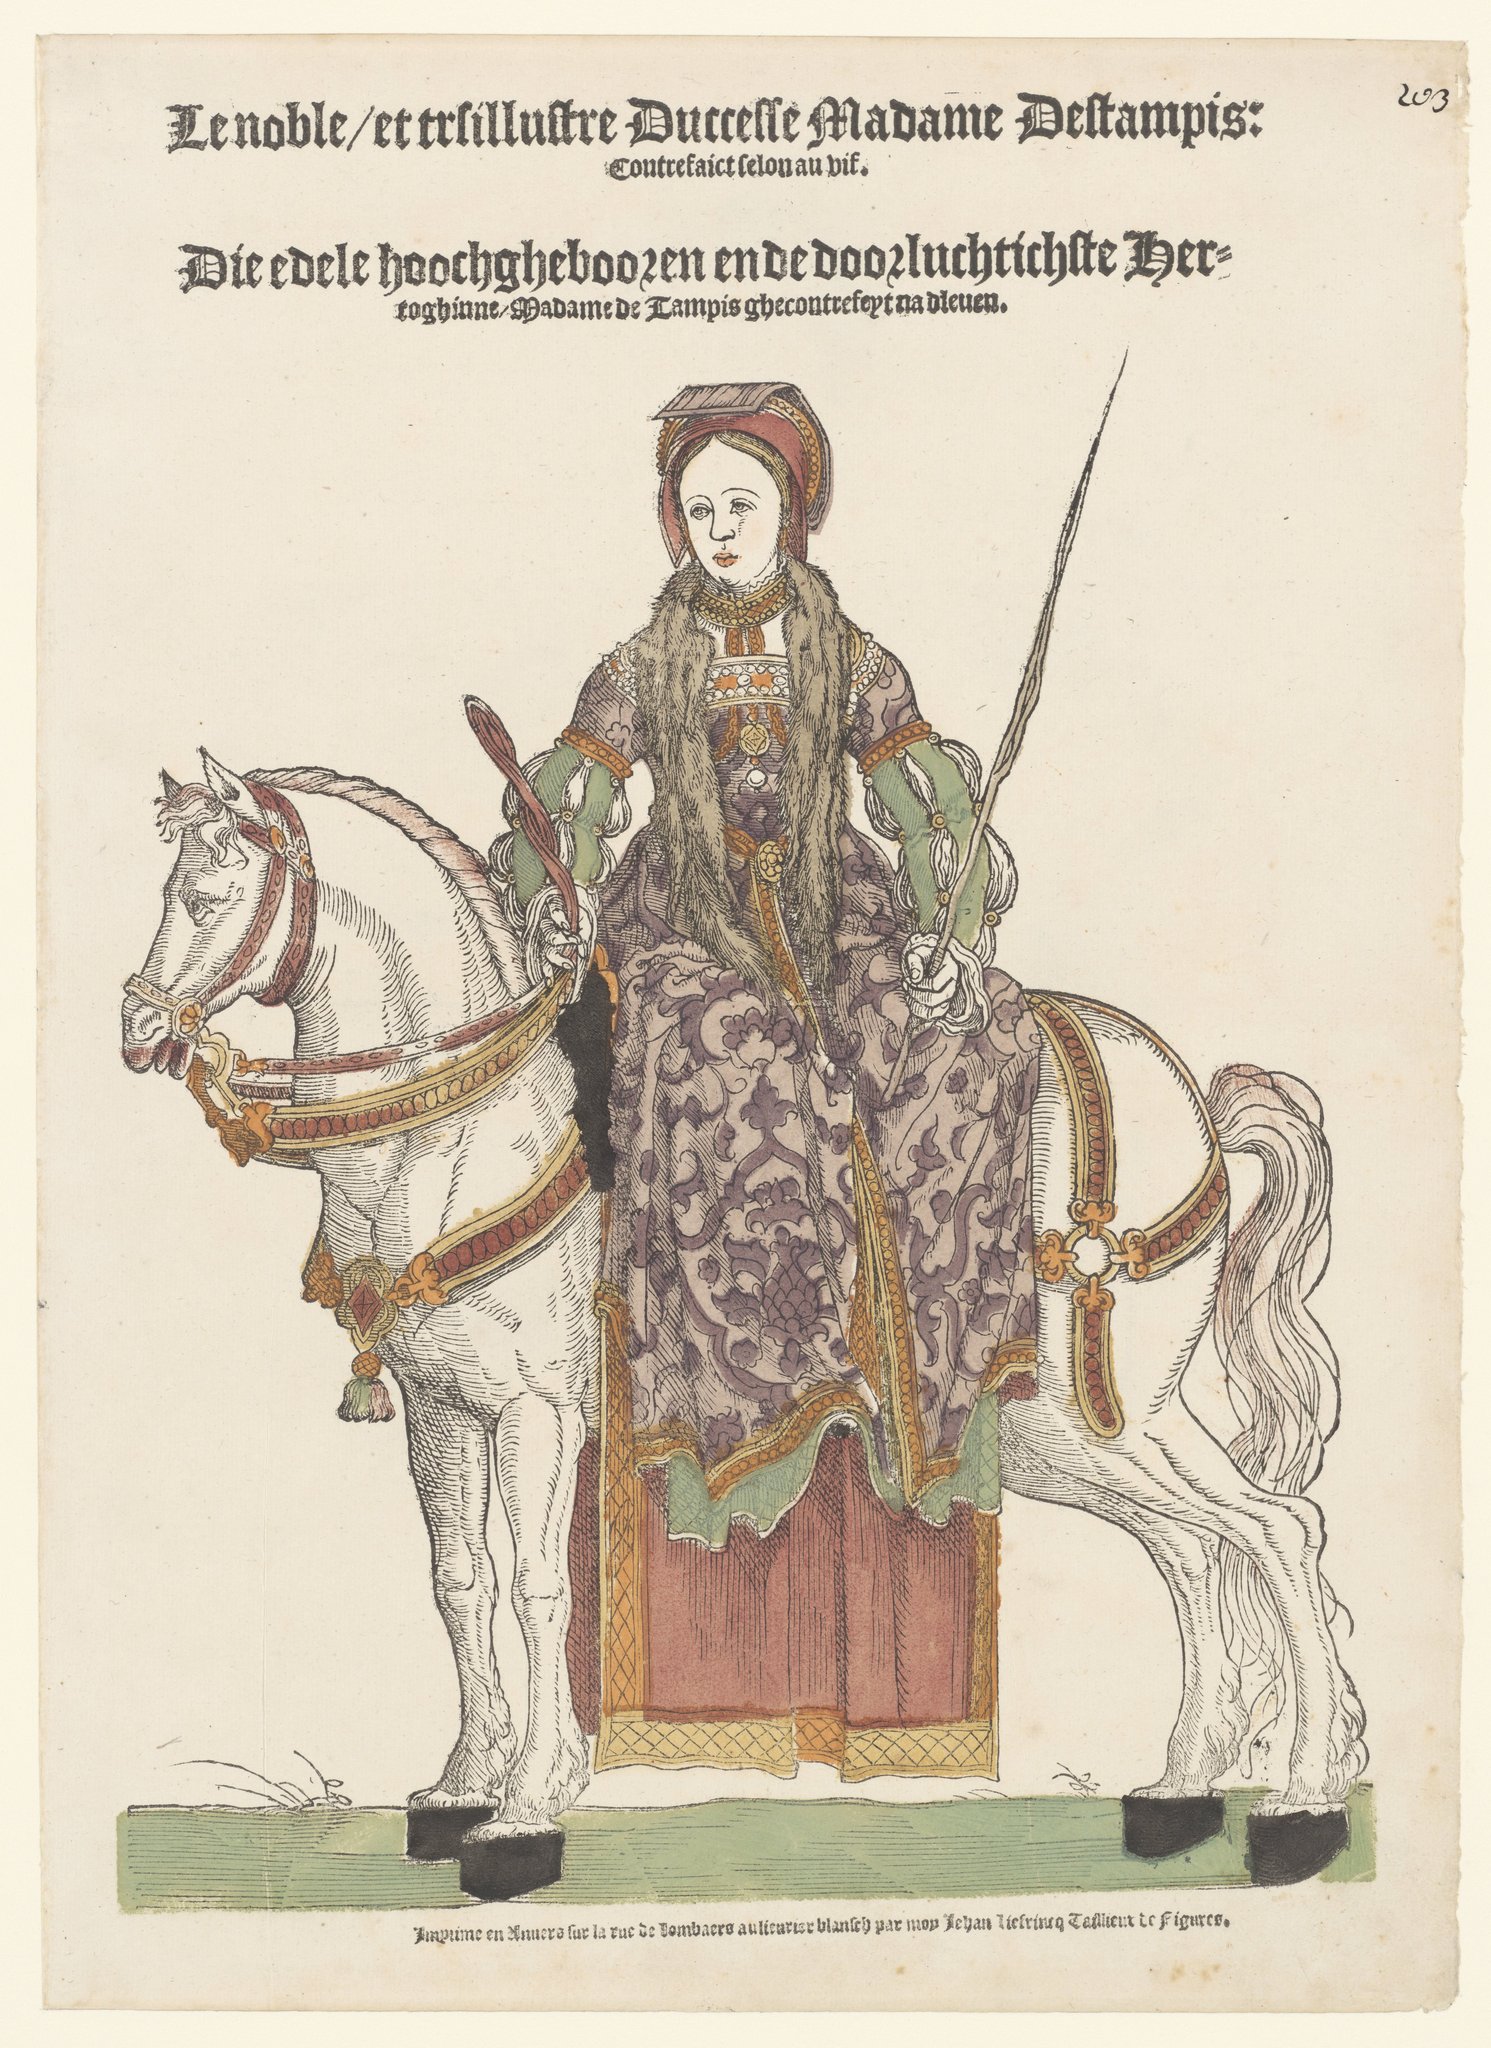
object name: print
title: Portret van Anne de Pisseleu te paard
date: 1539-1553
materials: paper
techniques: hand coloring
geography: antwerp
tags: equestrian state-portrait, historical persons - bb - woman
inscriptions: number: ‘203’, inscription: ‘Le noble/ et tel illustre Duchesse Madame Destampis: Contrefaict selon au vif. Die edele hoochghebooren ende doorluchtichste Her-toghinne/ Madame de Tampis ghecontrefeyr na dleven’, address: ‘Imprime en Anvers sur la rue de Lombaers....Jehan Liefrincq Tailleur de Figueres’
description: Anne de Pisseleu, hofdame van koningin-moeder Louise van Savoye en sinds 1530 maîtresse van Frans I(1494-1547) die haar in 1533 uithuwelijkte aan Jean de Brosses aan wie hij, bij die gelegenheid, de titel Comte d'Etampes toekende. Anne d'Etampes behield haar invloed aan het hof tot aan de dood van Frans I. Zij is afgebeeld als amazone op een stilstaand paard. Het is volgens opschrift 'ghecontrefeyt na dleven'.